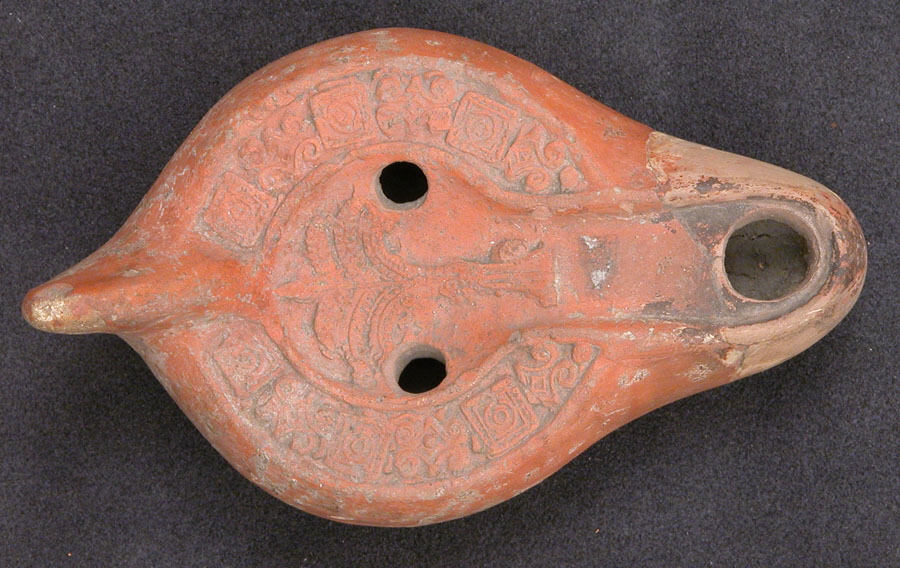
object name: lamp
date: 401-600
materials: earthenware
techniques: molding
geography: egypt